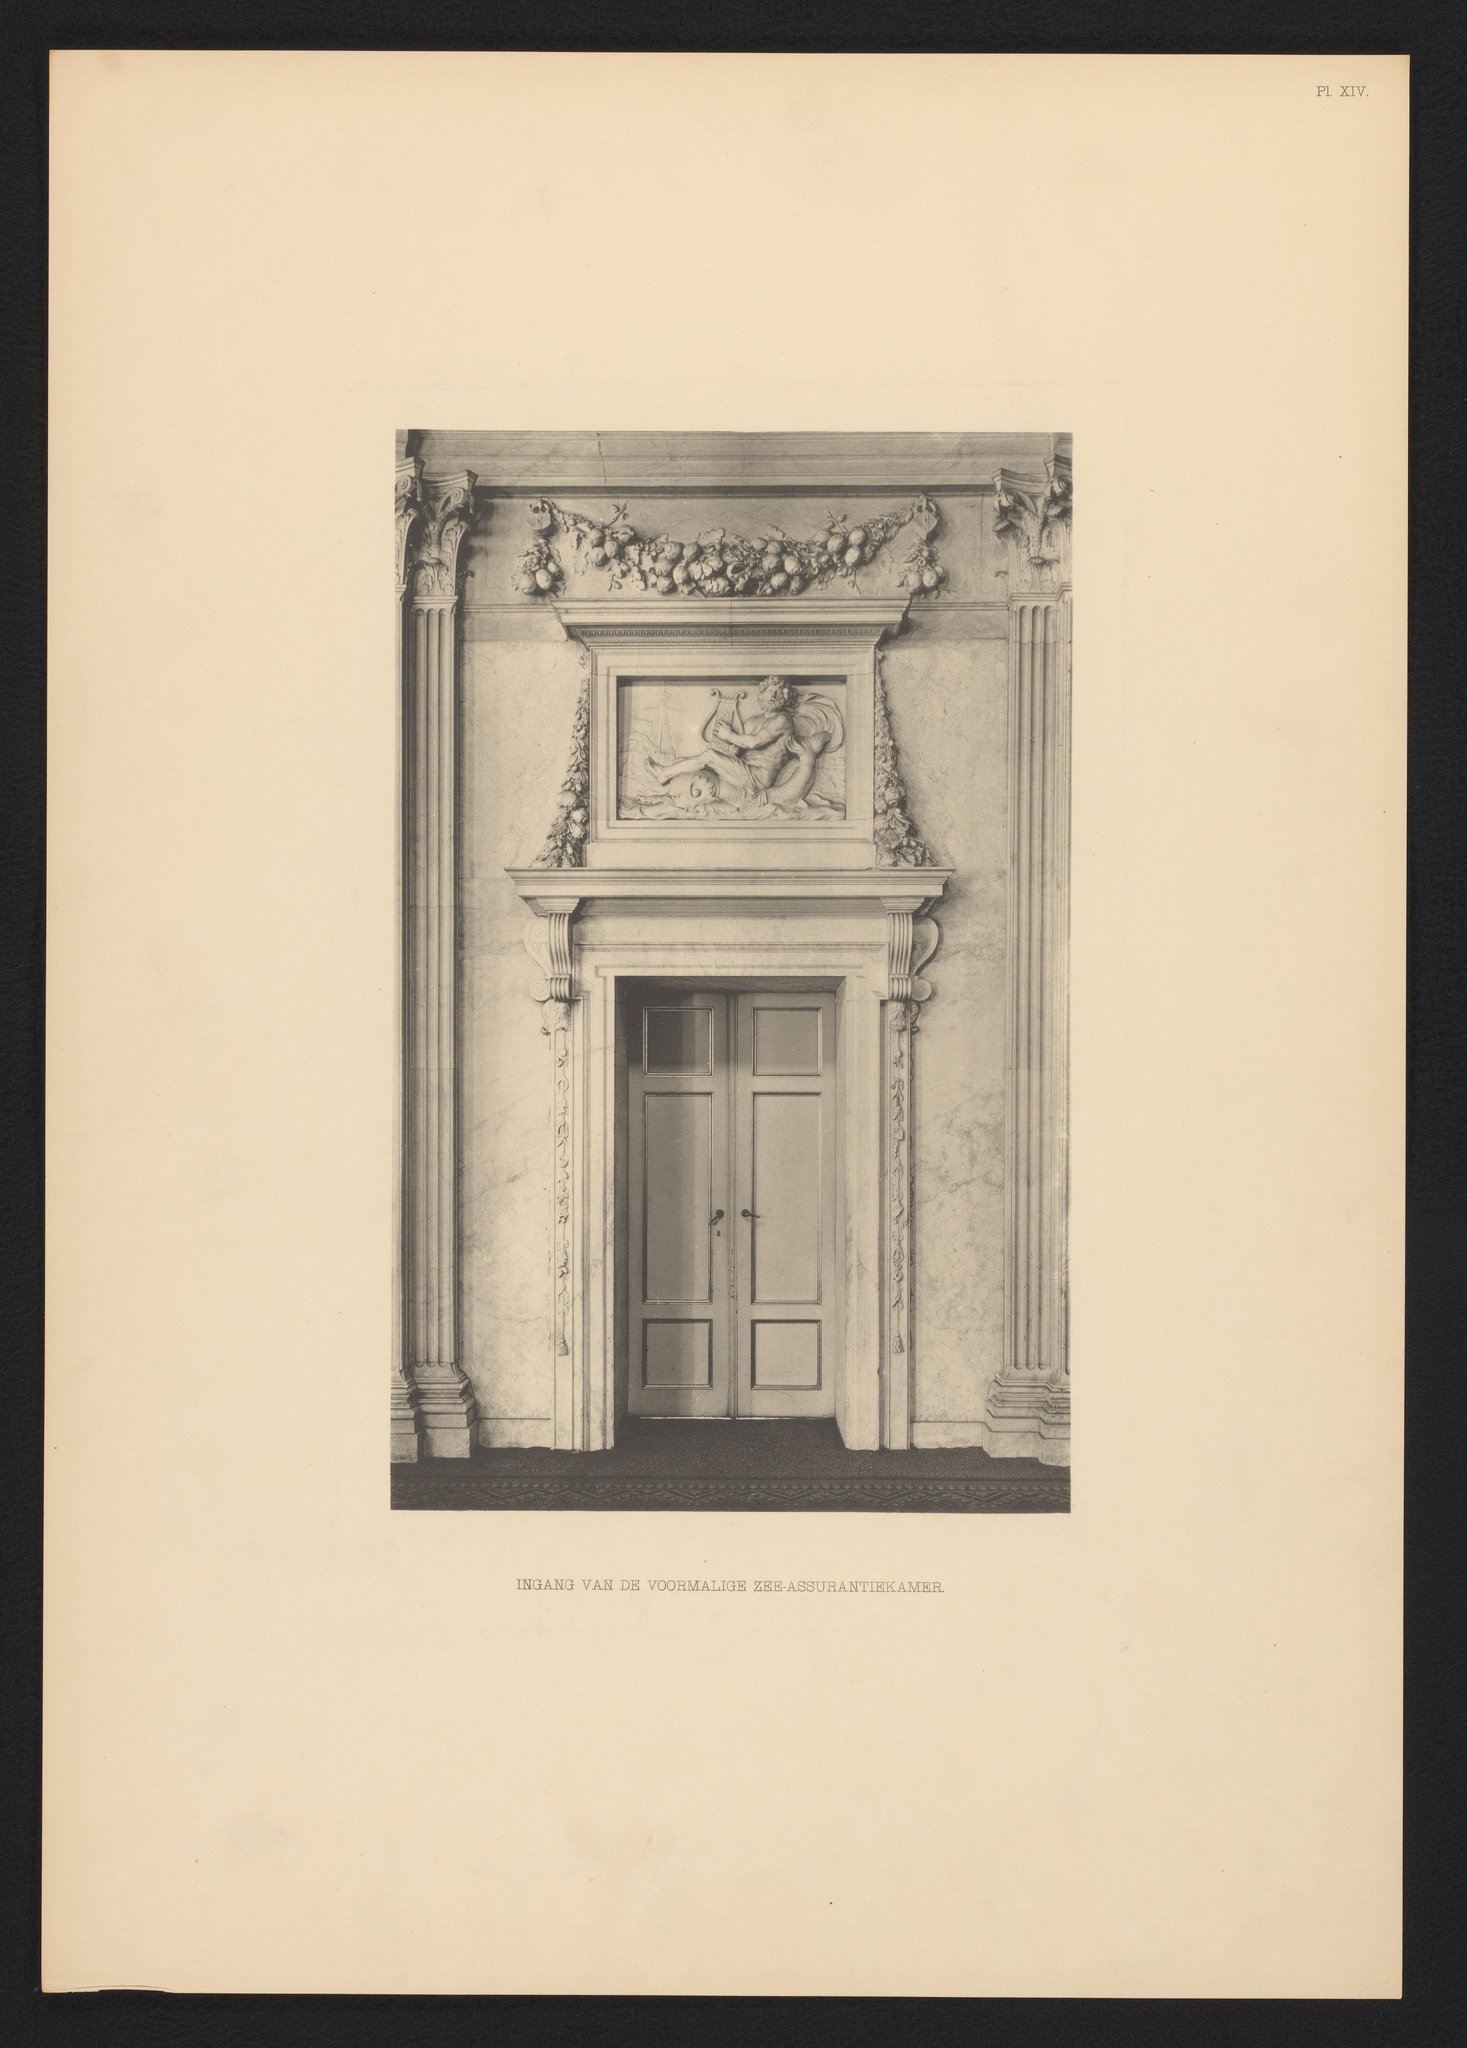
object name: photograph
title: C.T.J. Louis Rieber, Het Koninklijk Paleis te Amsterdam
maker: Anonymous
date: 1899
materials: cardboard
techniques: photograph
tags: palace, door, royal palace of amsterdam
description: Ingang van de voormalige Zee-assurantiekamer.